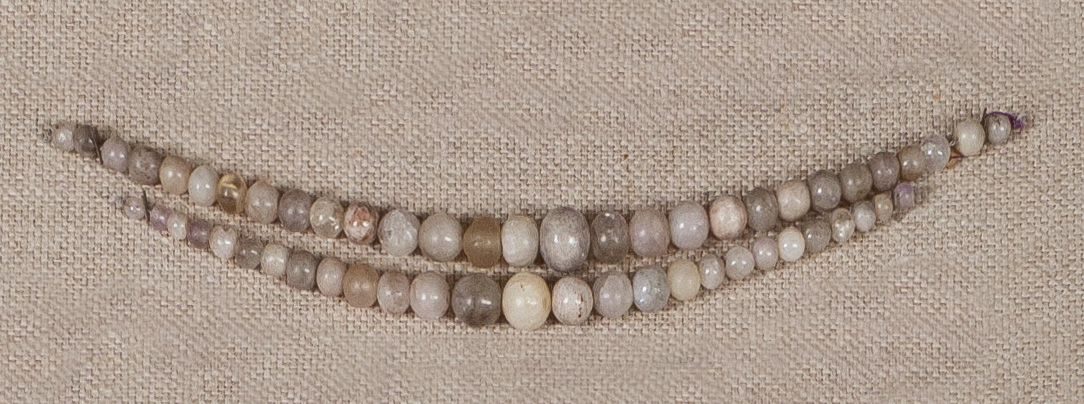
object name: necklace, bead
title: String of Quartz Ball Beads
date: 1981-1295 BCE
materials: quartz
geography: egypt